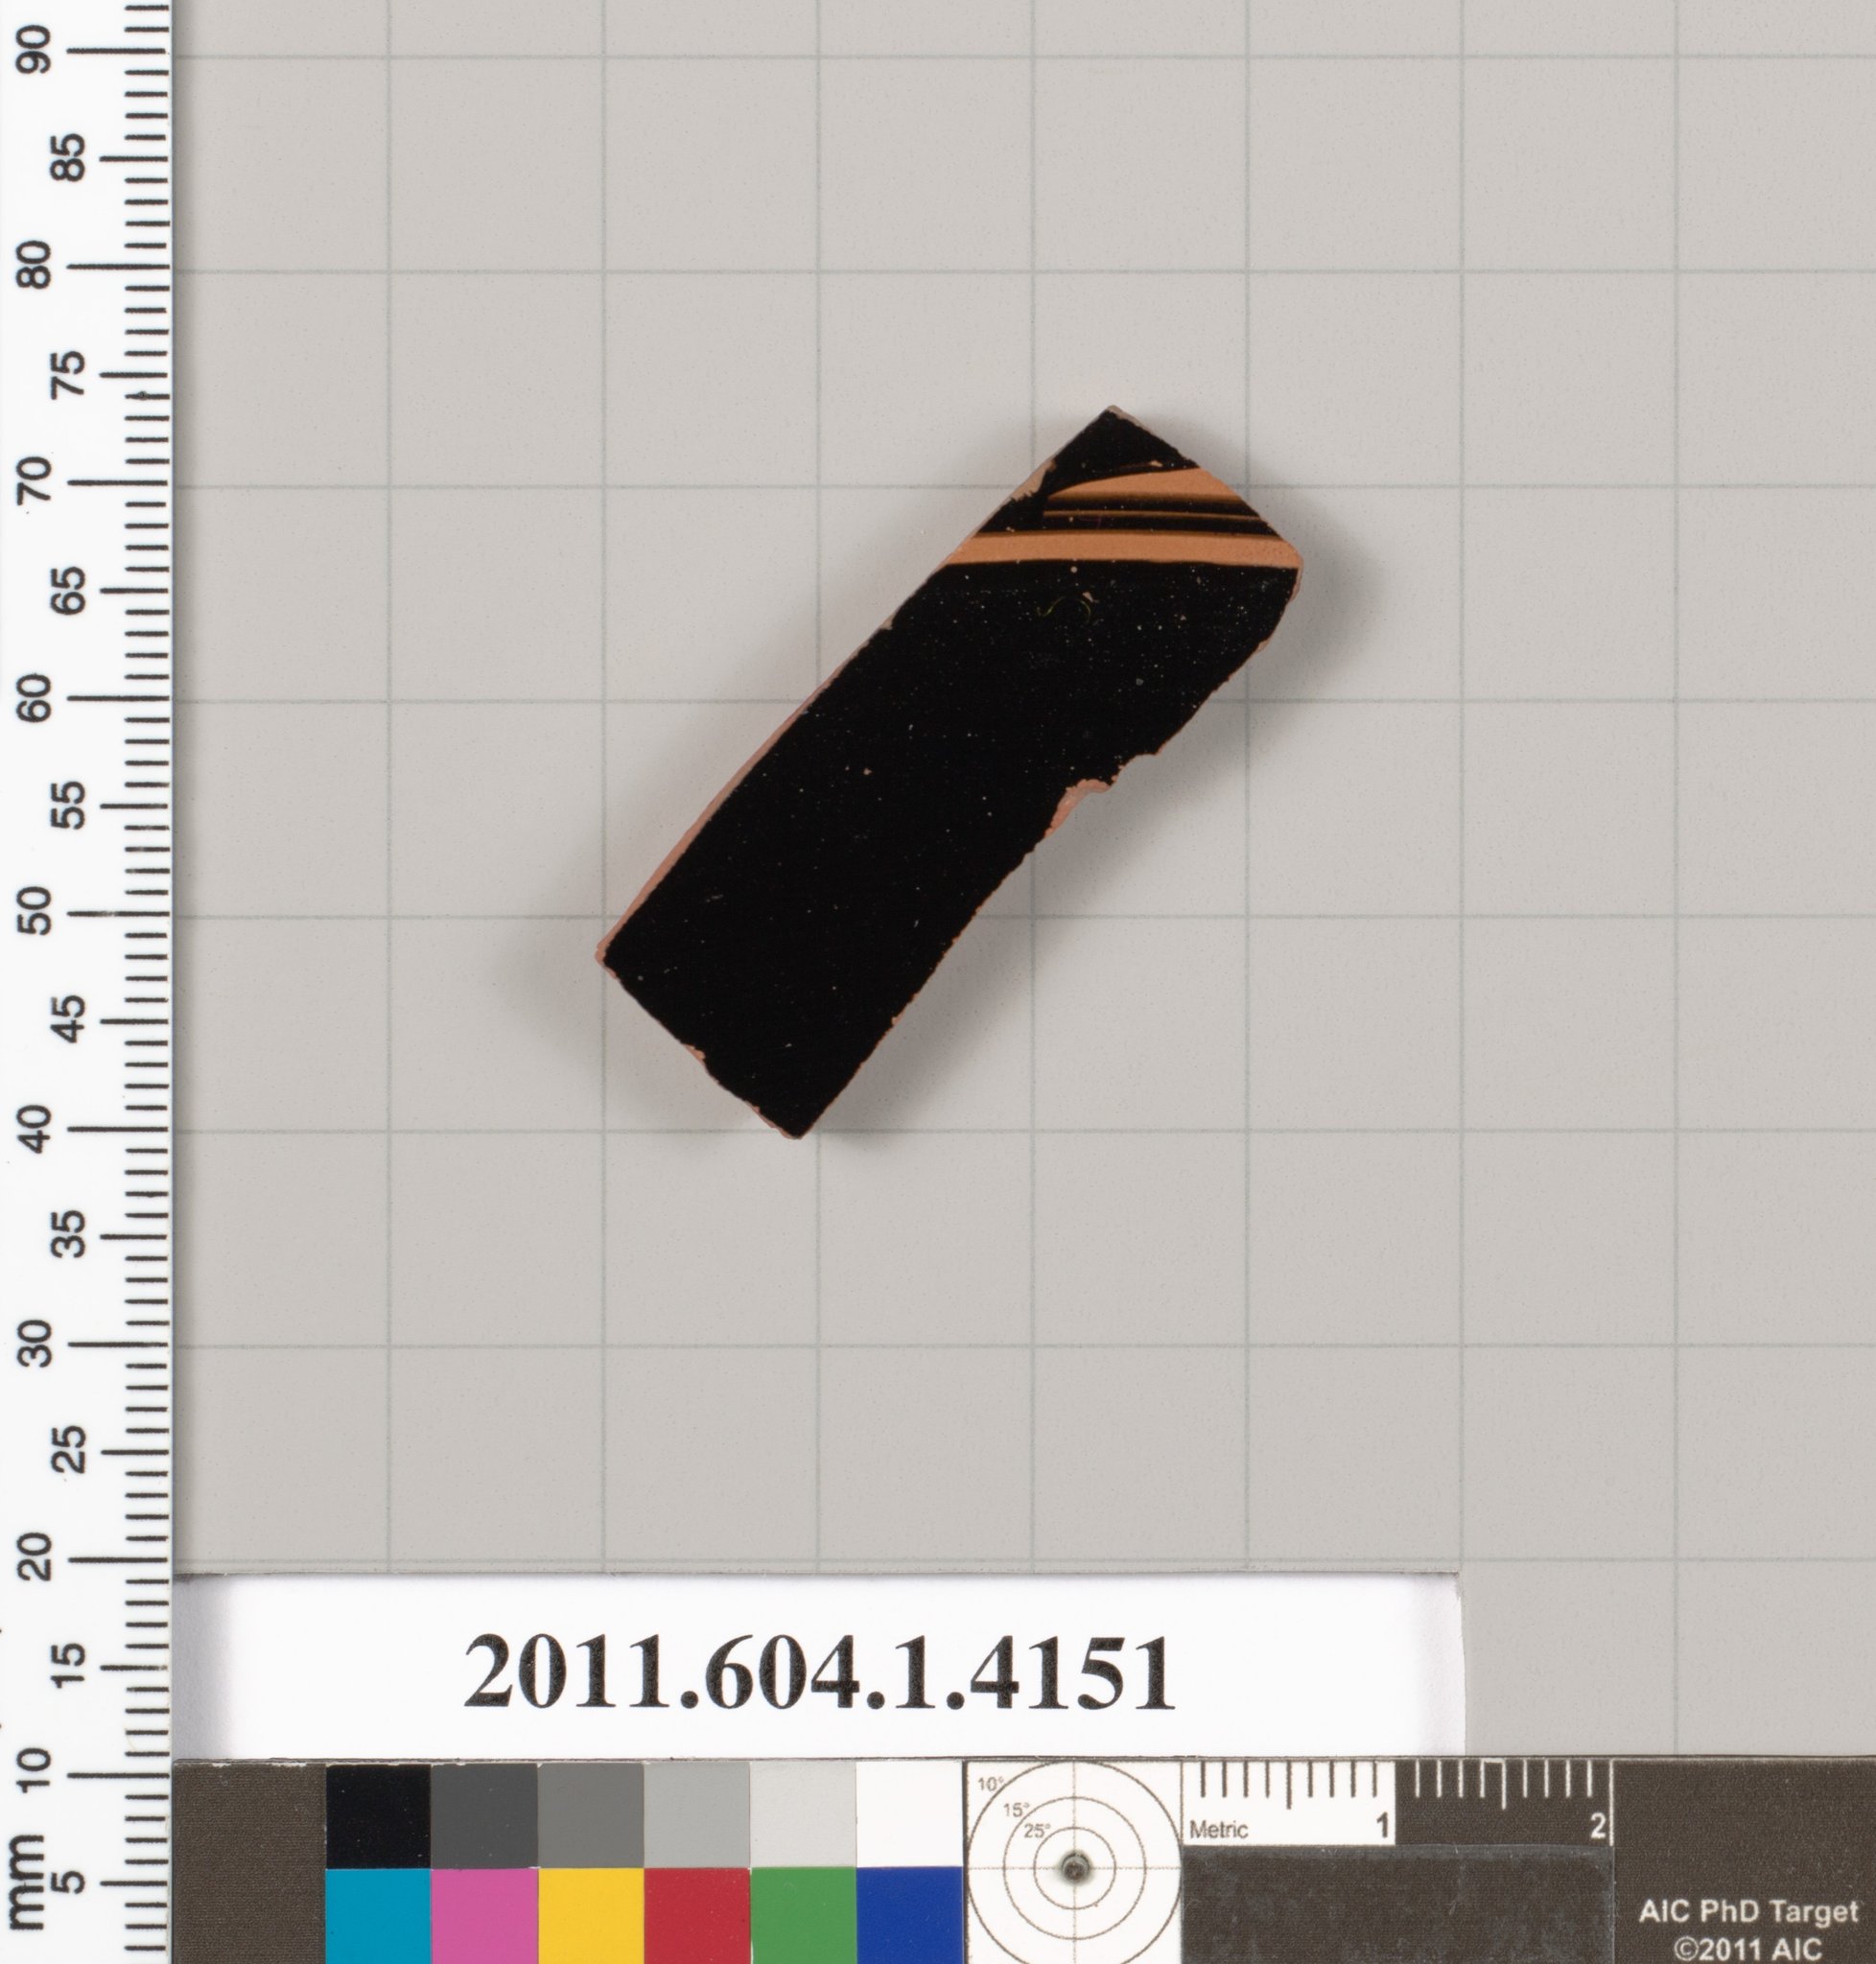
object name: kylix fragment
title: Terracotta fragment of a kylix (drinking cup)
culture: greek, attic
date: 500-451 BCE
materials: terracotta